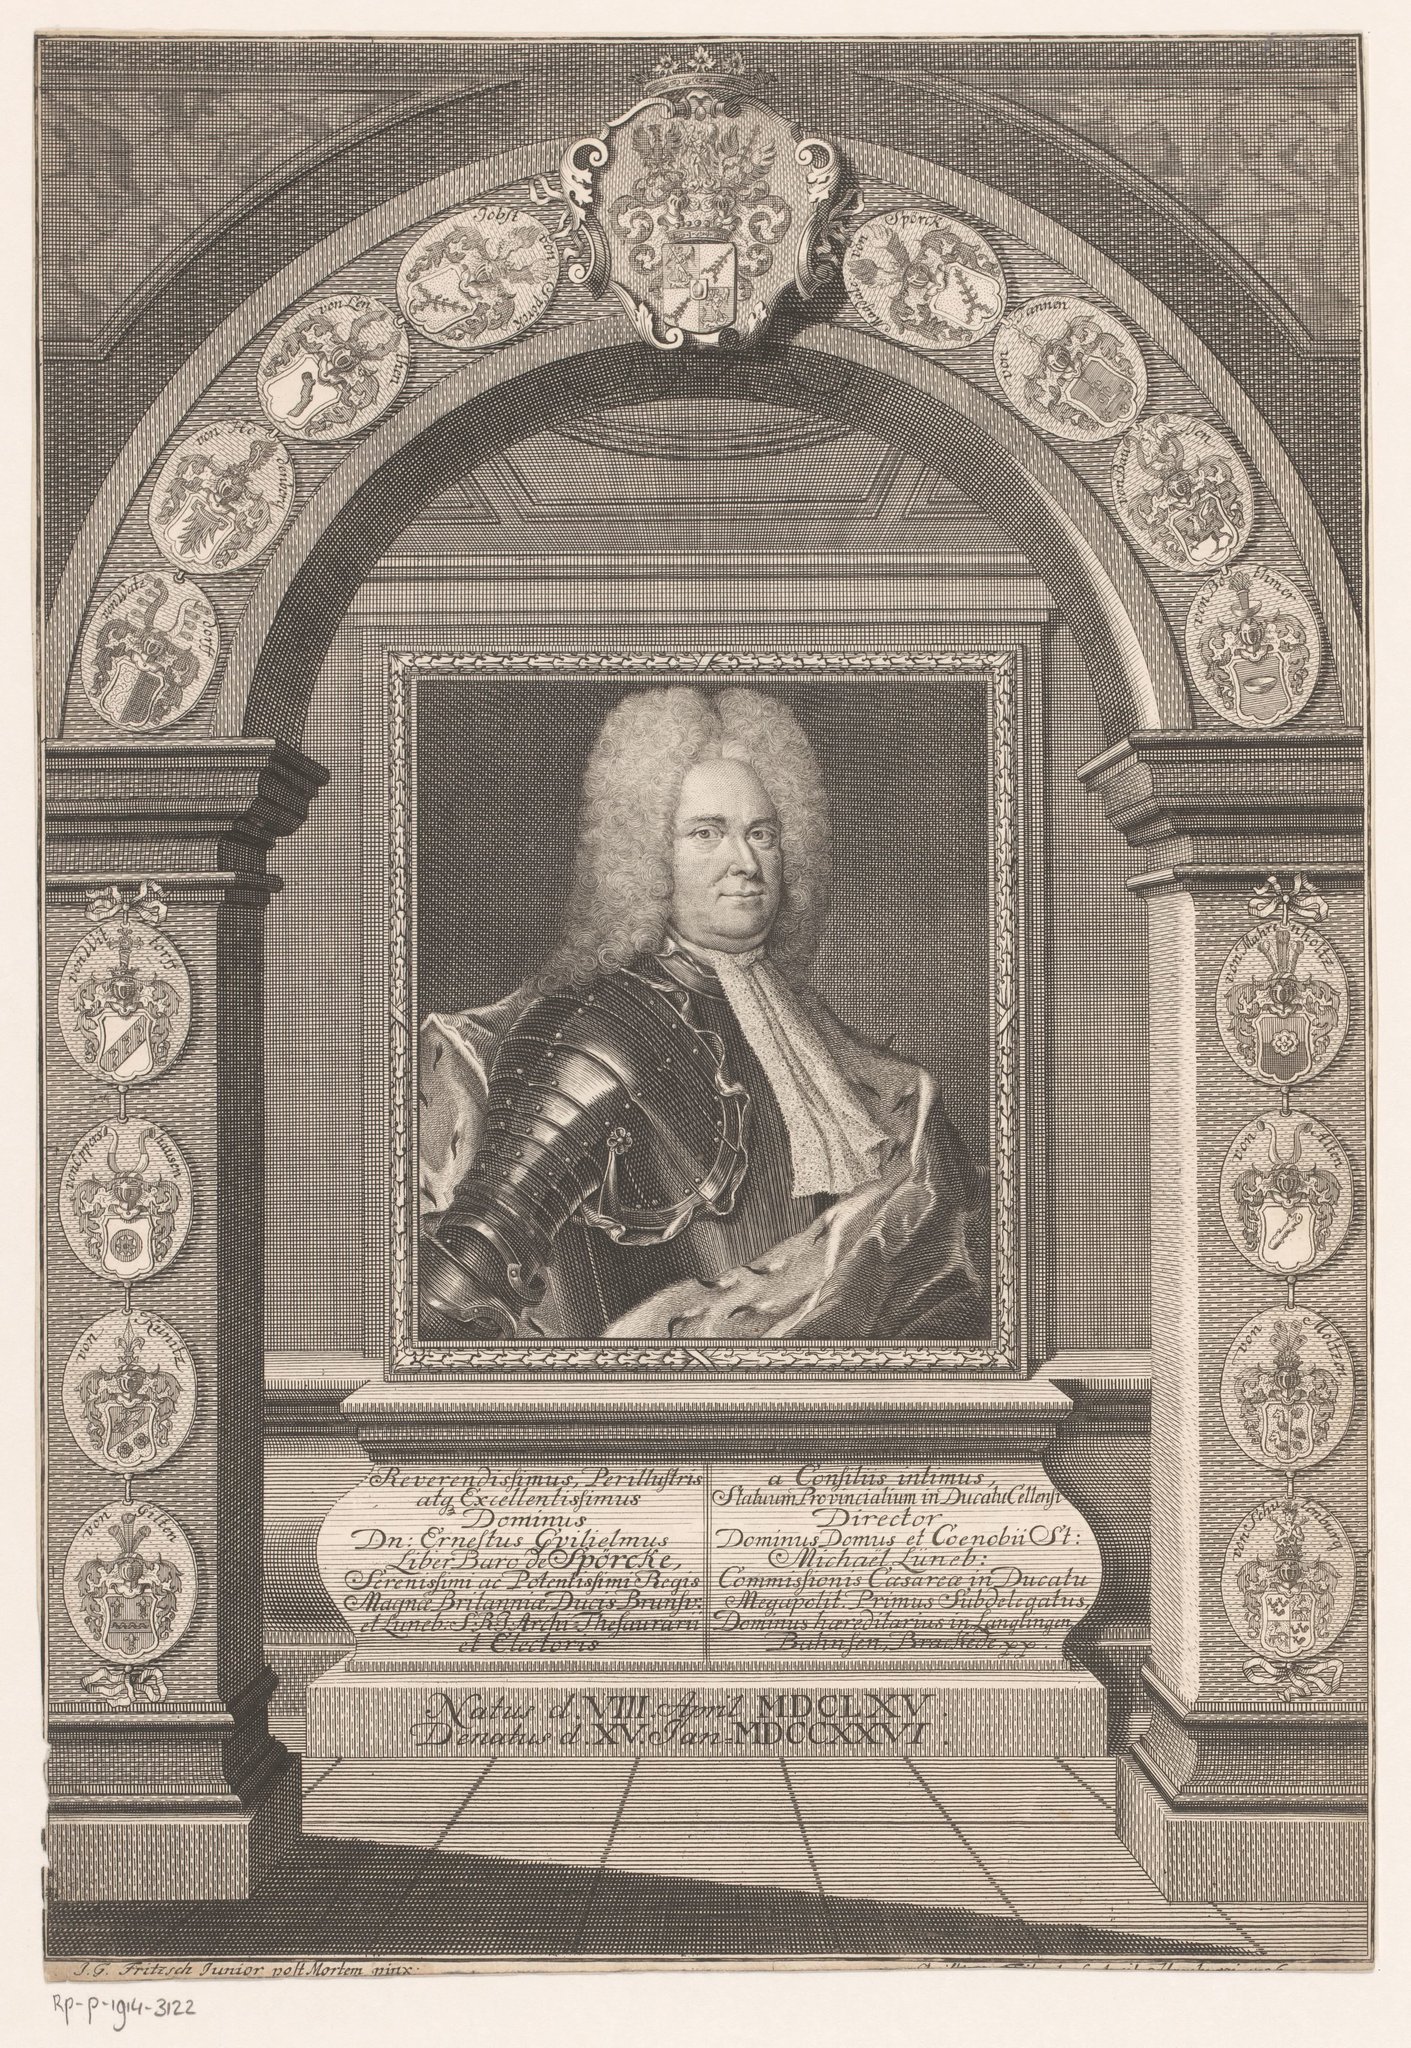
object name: print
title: Portret van Ernst Wilhelm von Spörcken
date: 1726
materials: paper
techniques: engraving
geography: hamburg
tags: armour, historical persons, arch, archivolt ~ architecture, mantle, gown, dress (symbol of sovereignty), ornament derived from architectural details, armorial bearing, heraldry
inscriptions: collector's mark: Lugt 2228